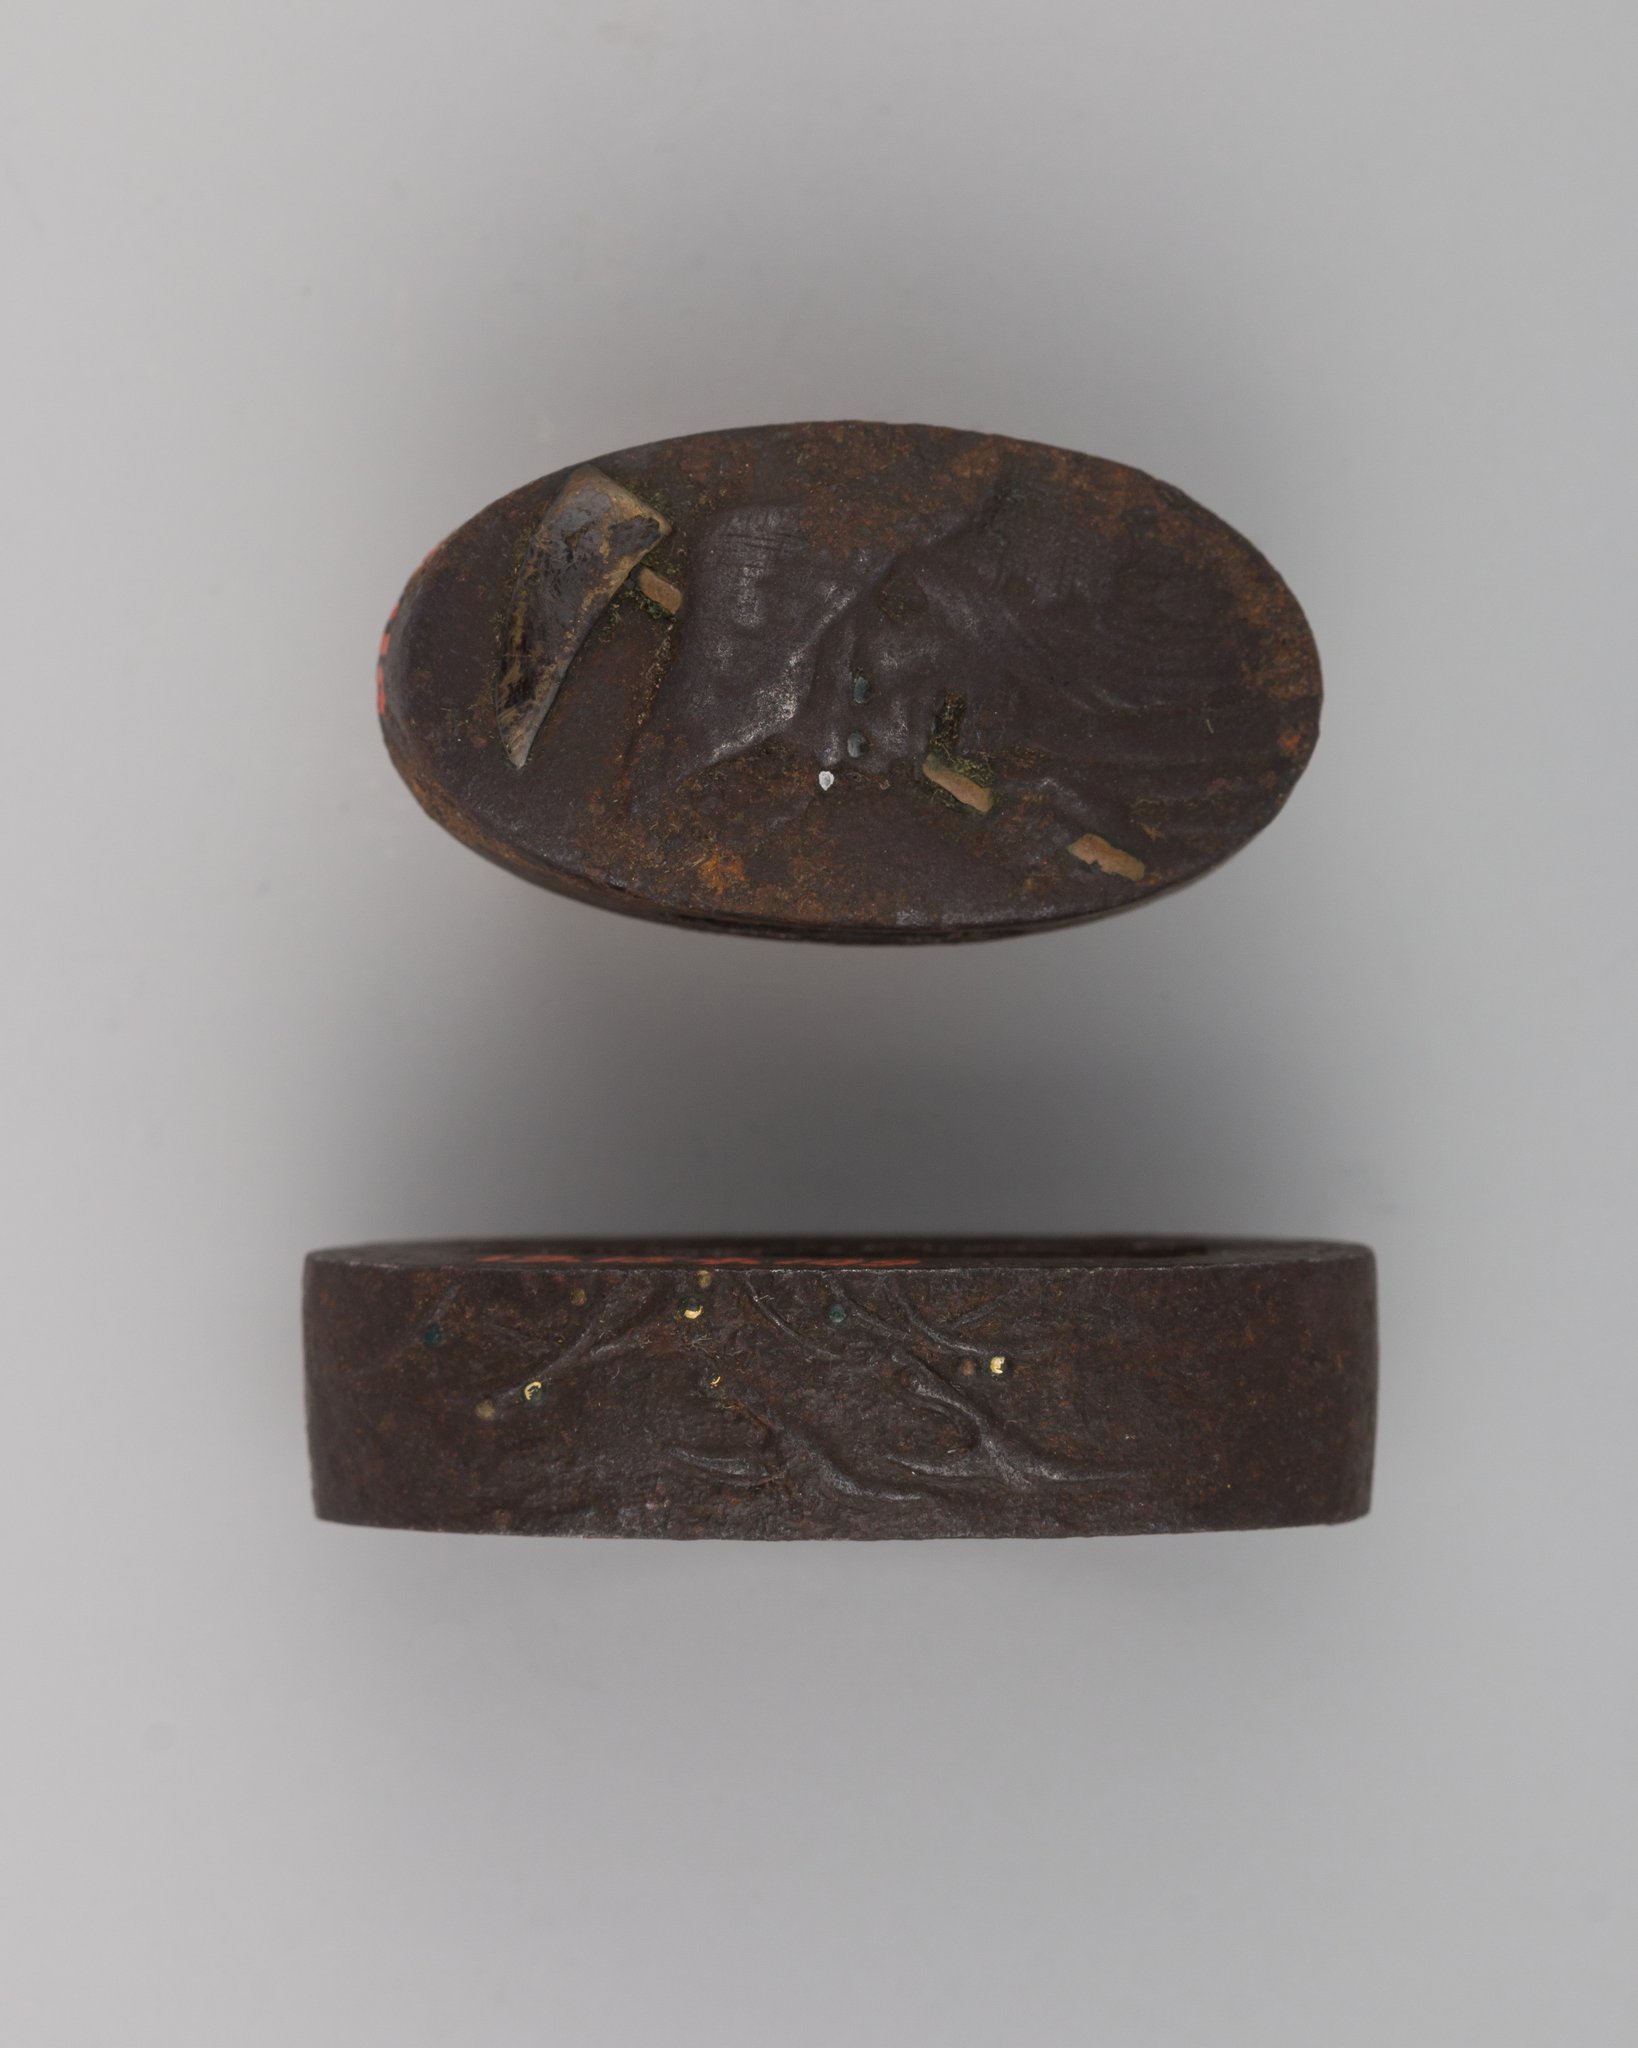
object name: sword hilt collar fuchi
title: Sword-Hilt Collar (Fuchi)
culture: japanese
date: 1615-1868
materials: gold, iron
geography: japan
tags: men